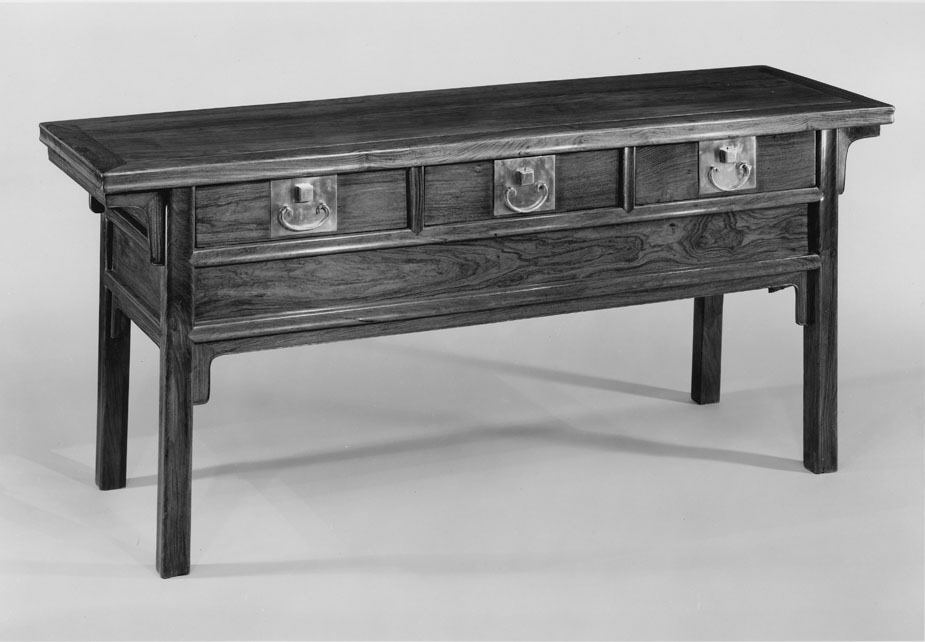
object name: altar coffer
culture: chinese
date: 1601-1800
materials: wood